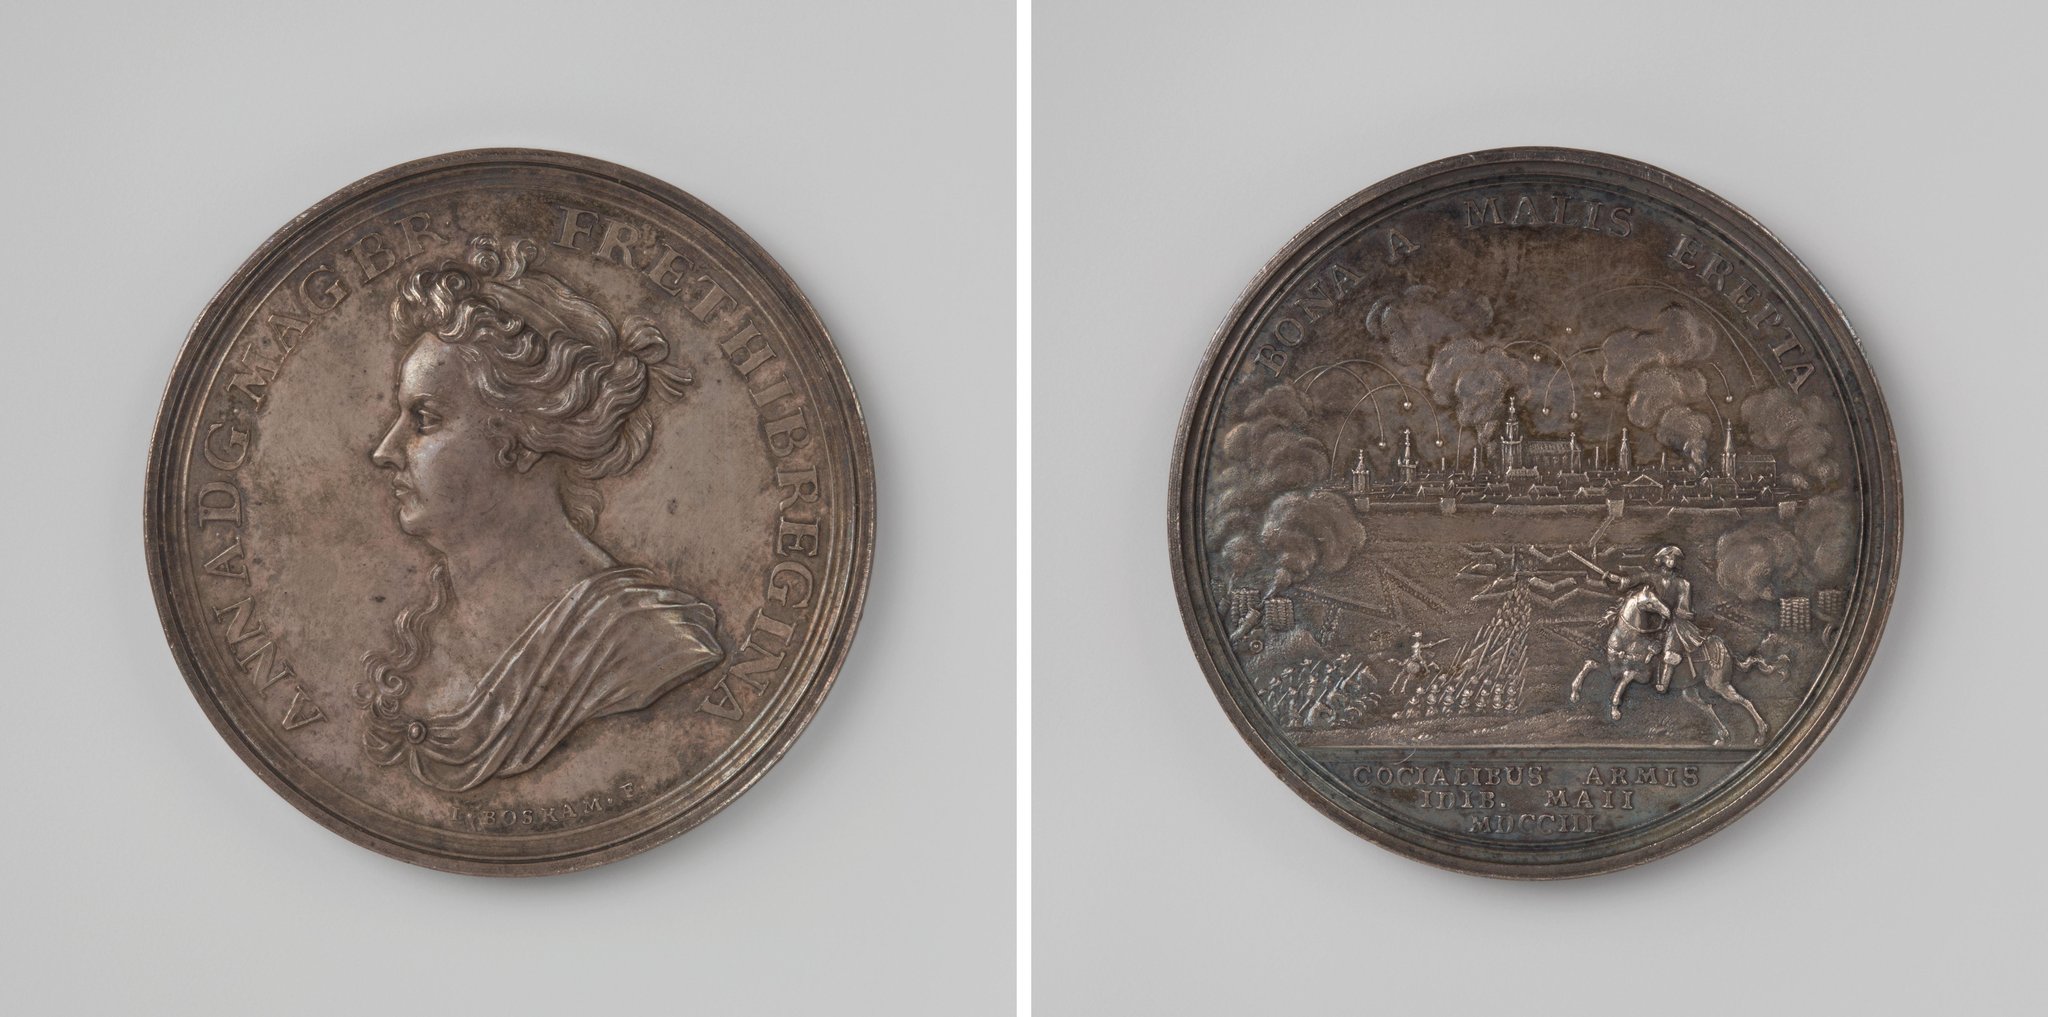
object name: history medal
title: Inname van Bonn door de bondgenoten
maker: jan boskam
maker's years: 1687-1708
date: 1703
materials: silver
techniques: striking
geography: nijmegen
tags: london, anna stuart (koningin van engeland en schotland)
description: Zilveren penning. Voorzijde: borststuk vrouw binnen omschrift. Keerzijde: beschieting van stad Bonn, op voorgrond hertog van Marlborough te paard met getrokken zwaard binnen omschrift, boven opschrift